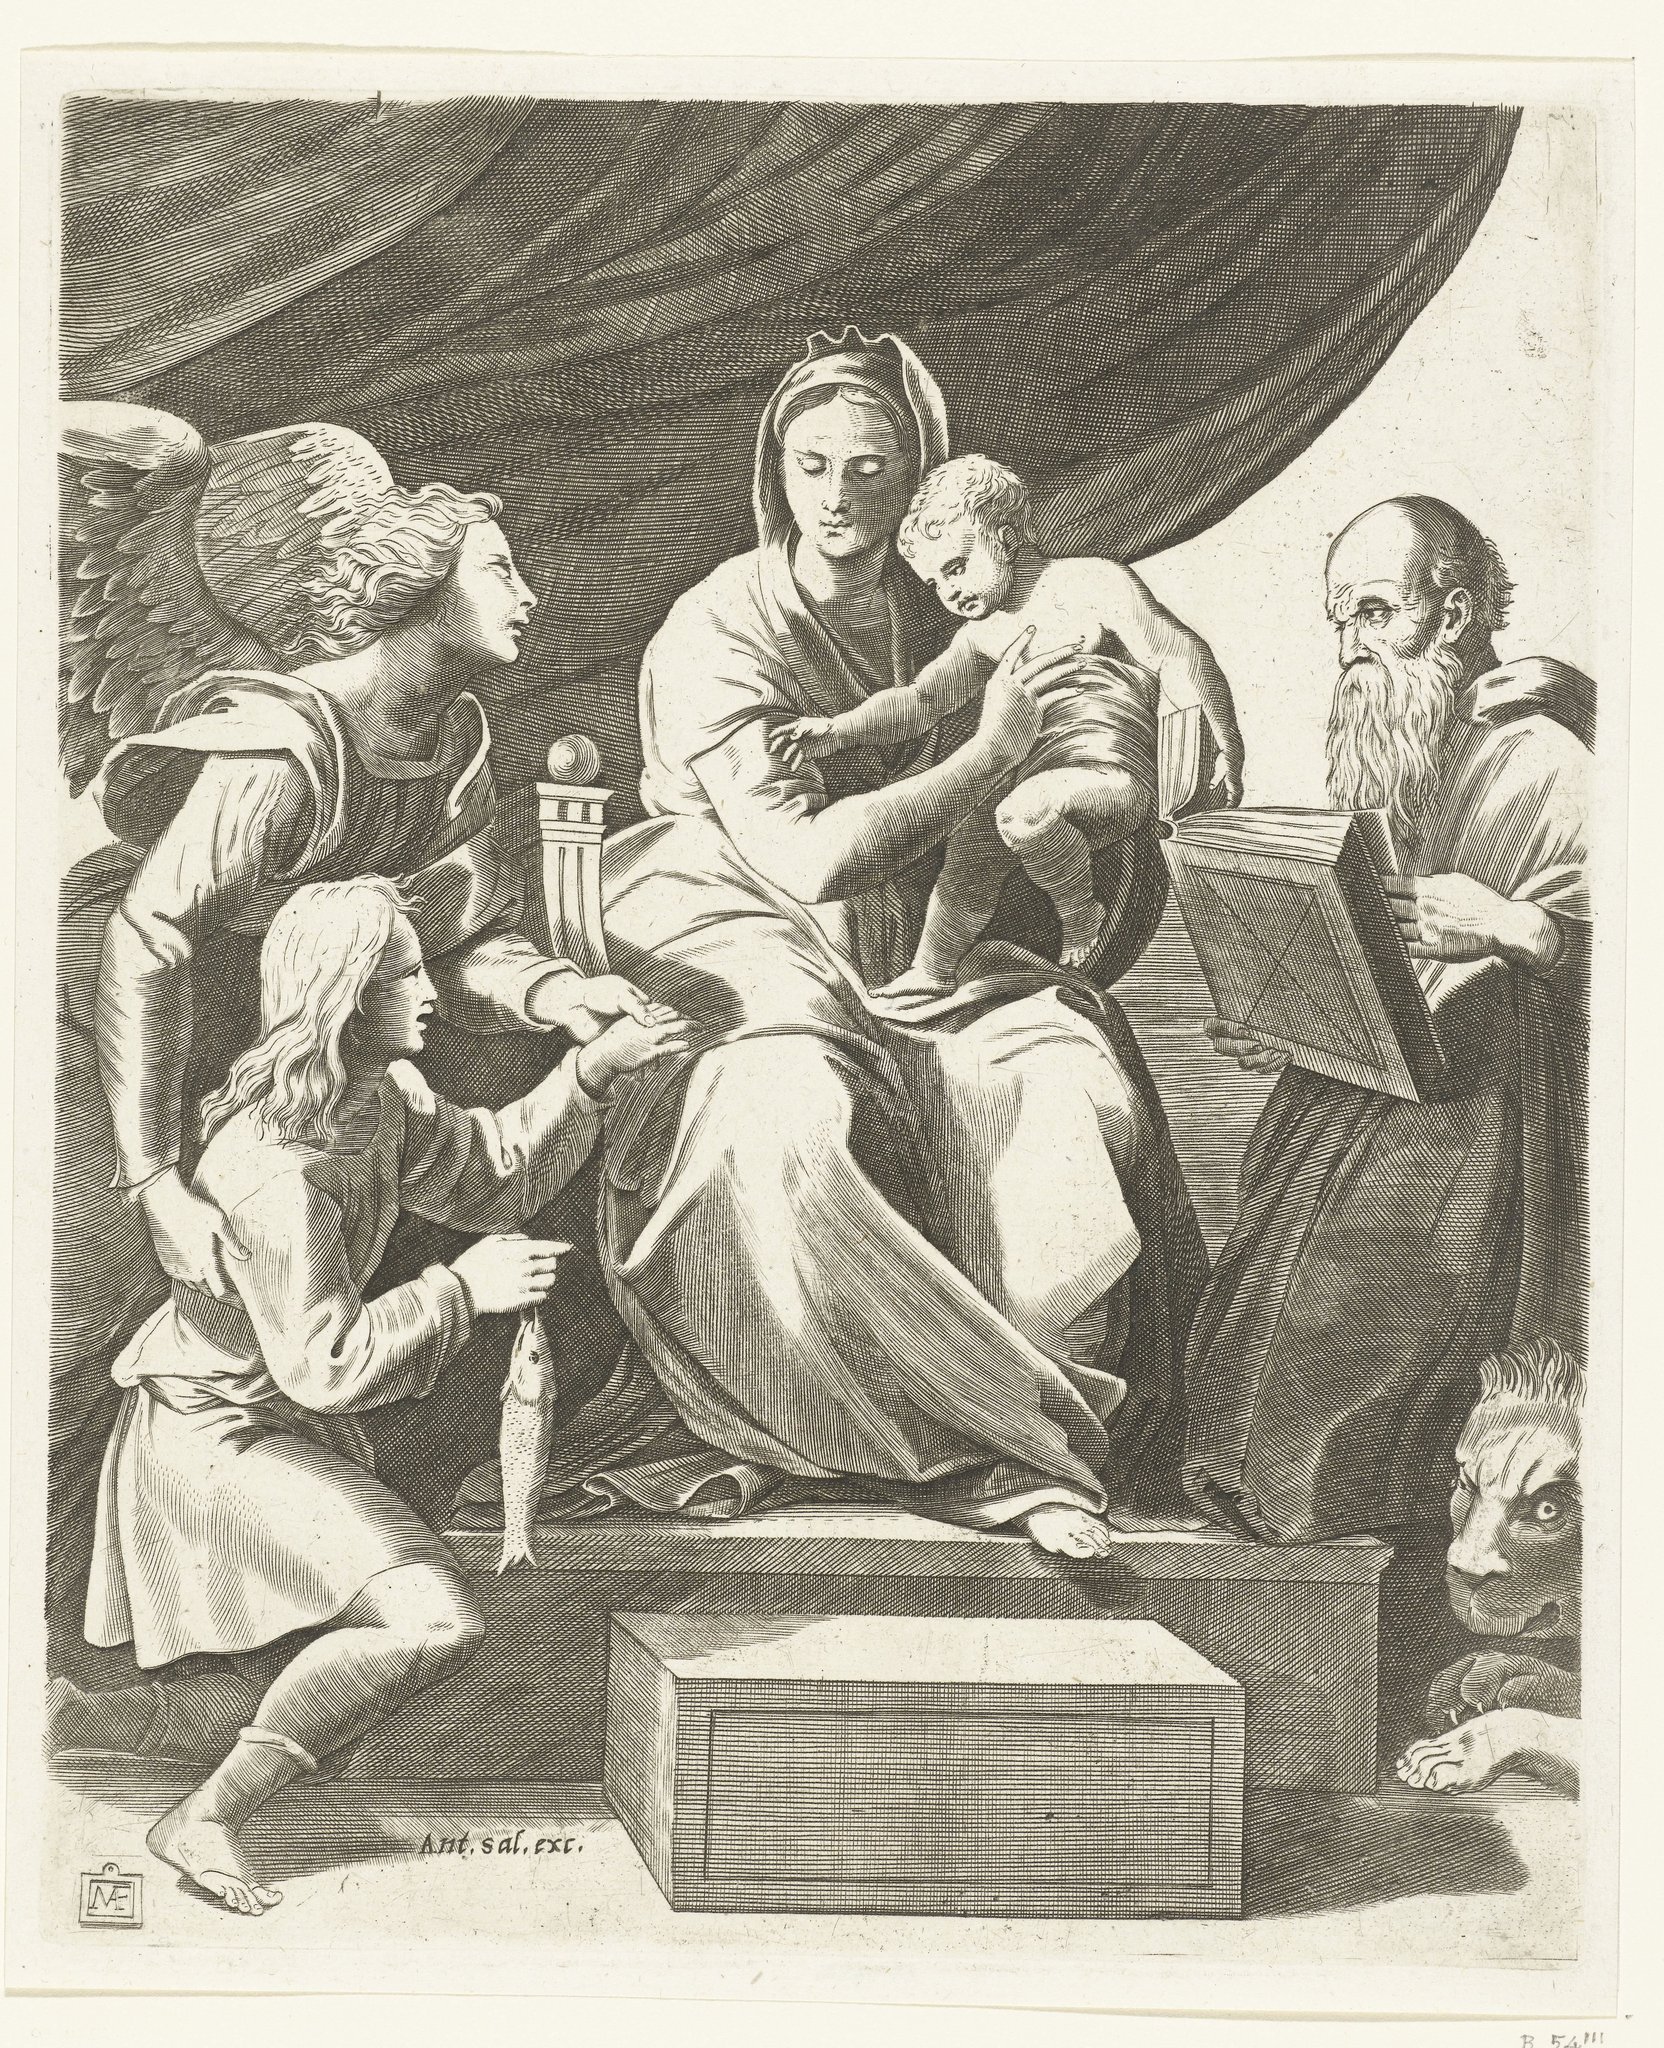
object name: print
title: Maria met kind geflankeerd door aartsengel Michaël met Tobias met vis en heilige Hieronymus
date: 1515-1550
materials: paper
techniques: engraving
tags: male persons from the old testament (with name) (not in biblical context), specific types of madonna with others, the monk and hermit jerome (hieronymus); possible attributes: book, cardinal's hat, crucifix, hour-glass, lion, skull, stone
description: Kopie naar prent van Marco Dente. Dente op zijn beurt liet zich inspireren door Raphael. Het monogram op het tablet is een valse verwijzing naar Marcantonio Raimondi.